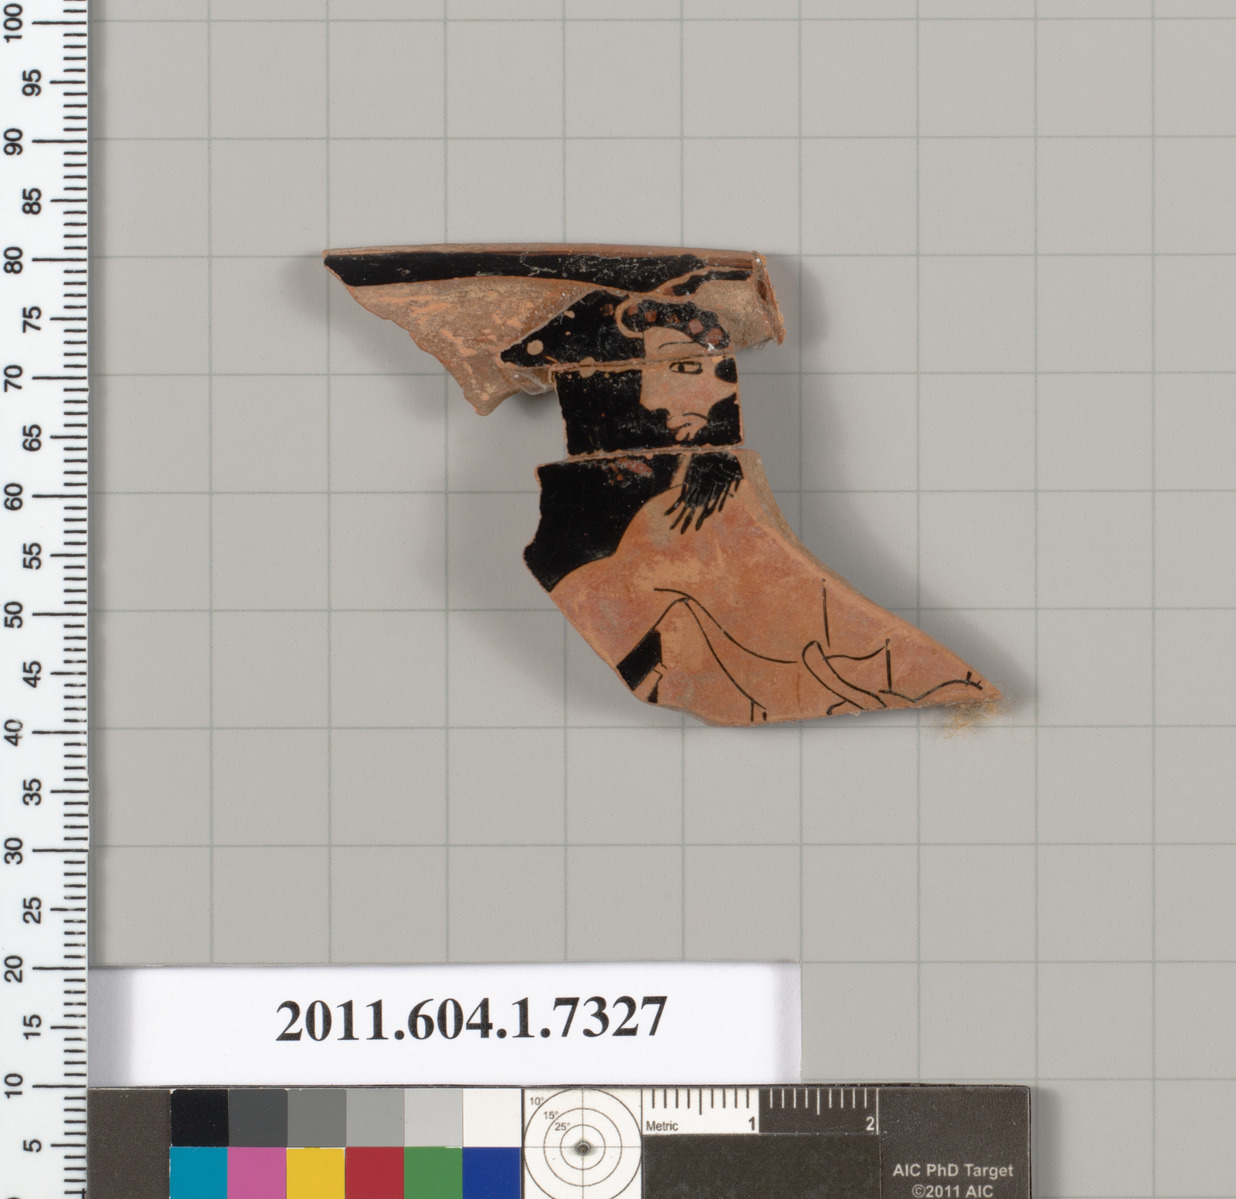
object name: kylix fragment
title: Terracotta rim fragment of a kylix (drinking cup)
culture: greek, attic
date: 500-480 BCE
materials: terracotta